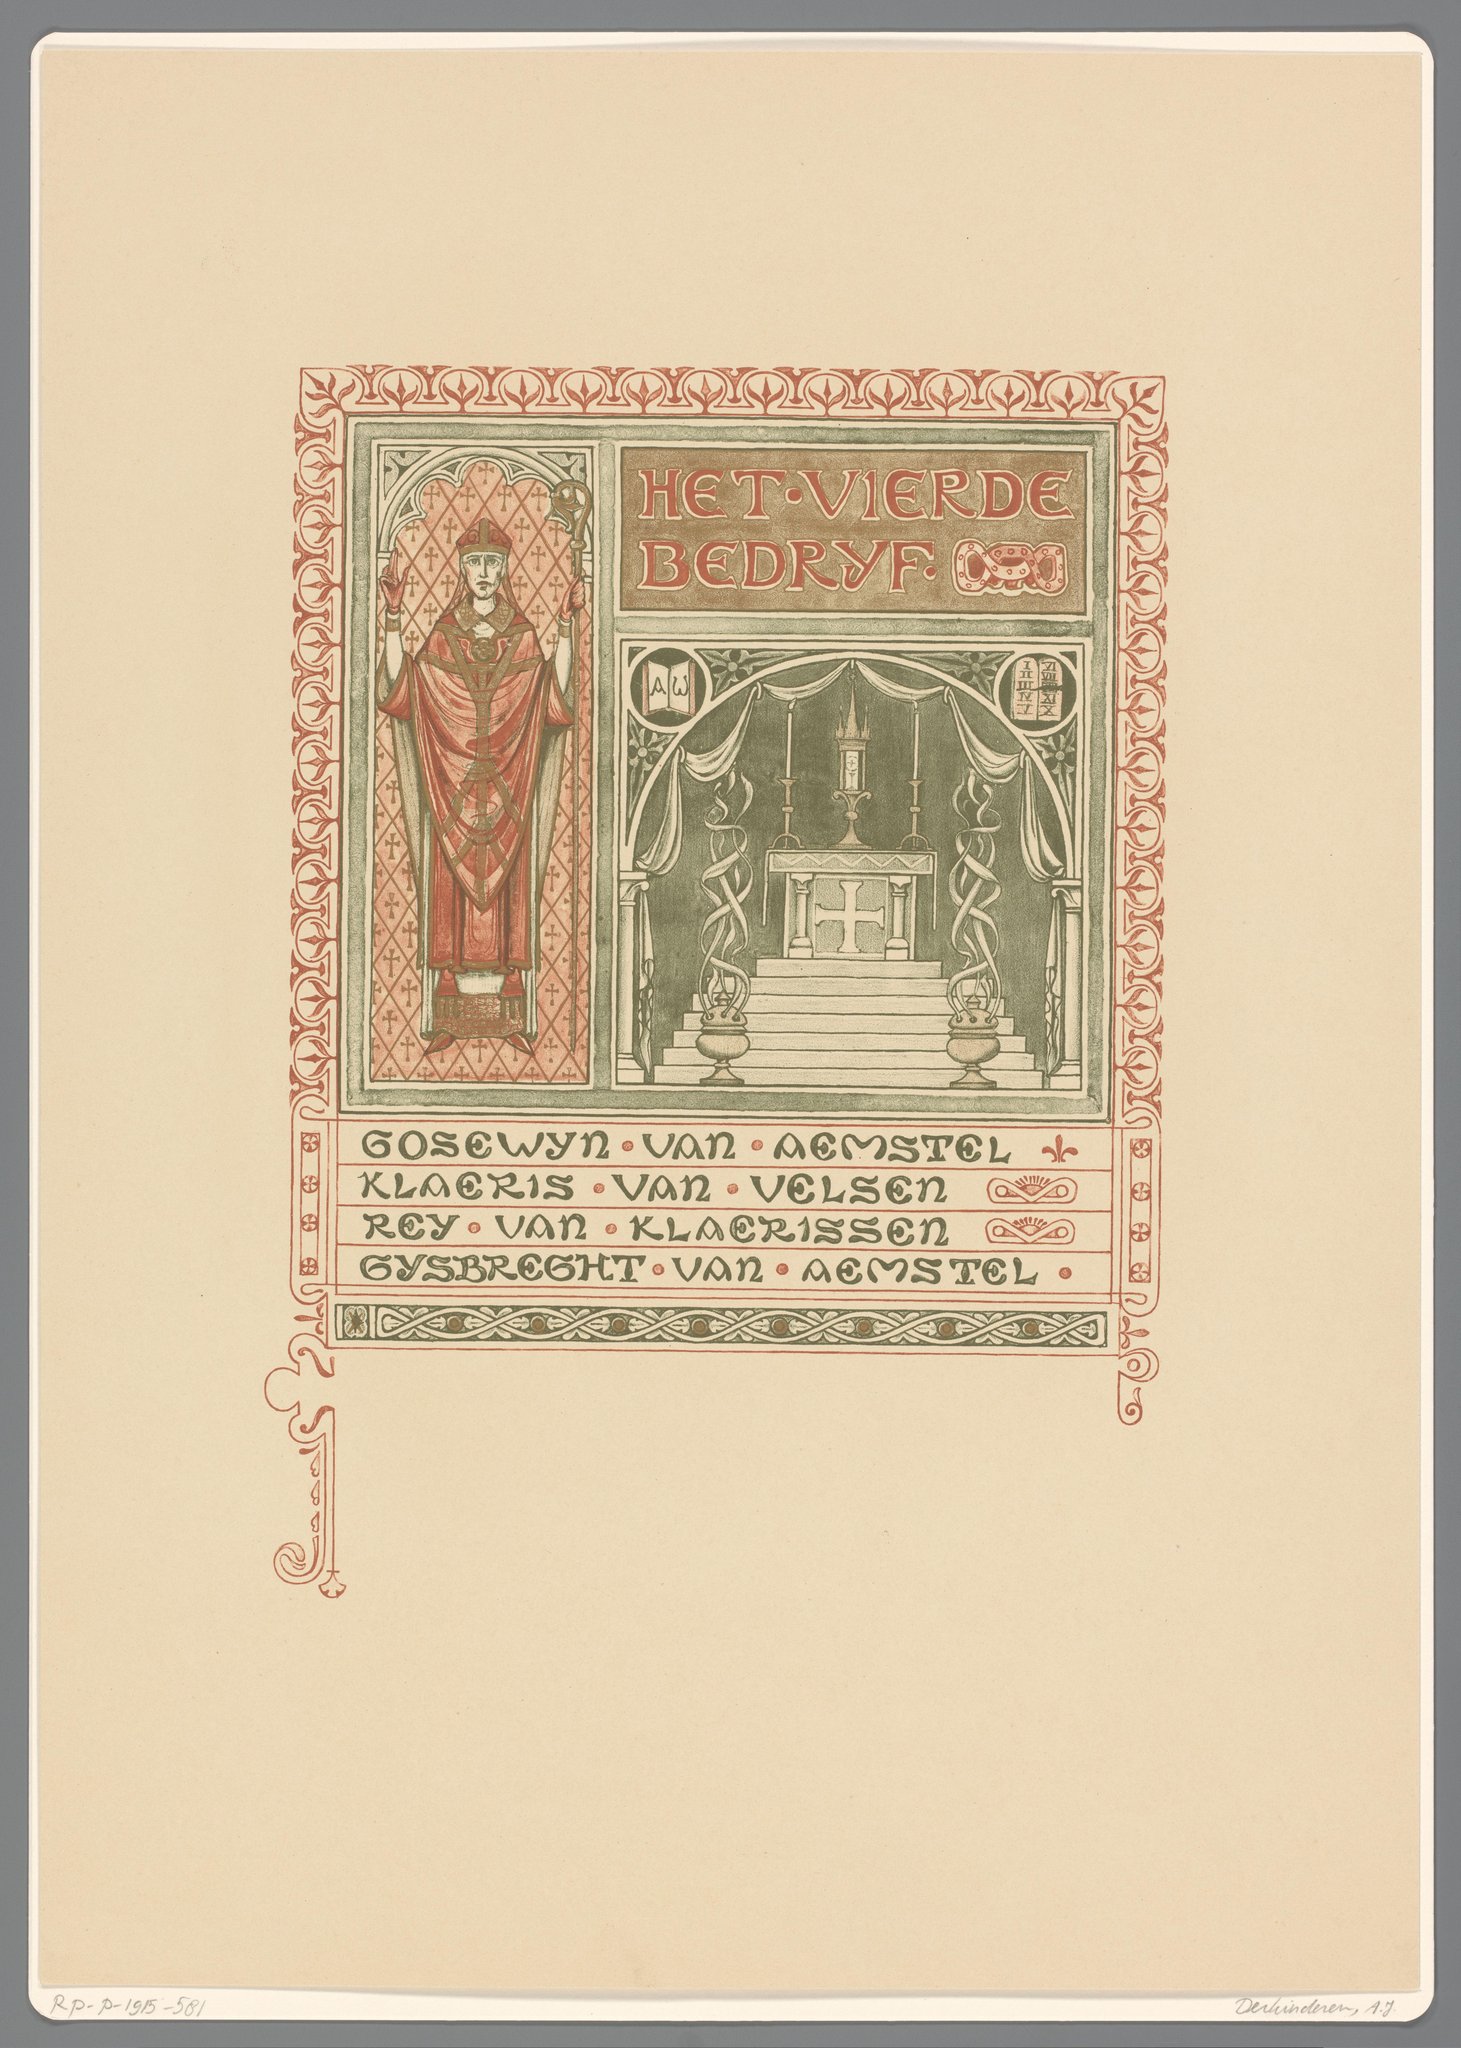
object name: book illustration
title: Het vierde bedryf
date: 1894-1901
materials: paper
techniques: lithograph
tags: archbishop, bishop, etc. (roman catholic), altar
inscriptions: collector's mark: Lugt 2233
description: Een geestelijke met mijter houdt een staf vast. Rechts van hem een altaar. Onderaan de tekst 'Gosewyn van Aemstel, Klaeris van Velsen, Rey van klaerissen, Gysbreght van Aemstel'.